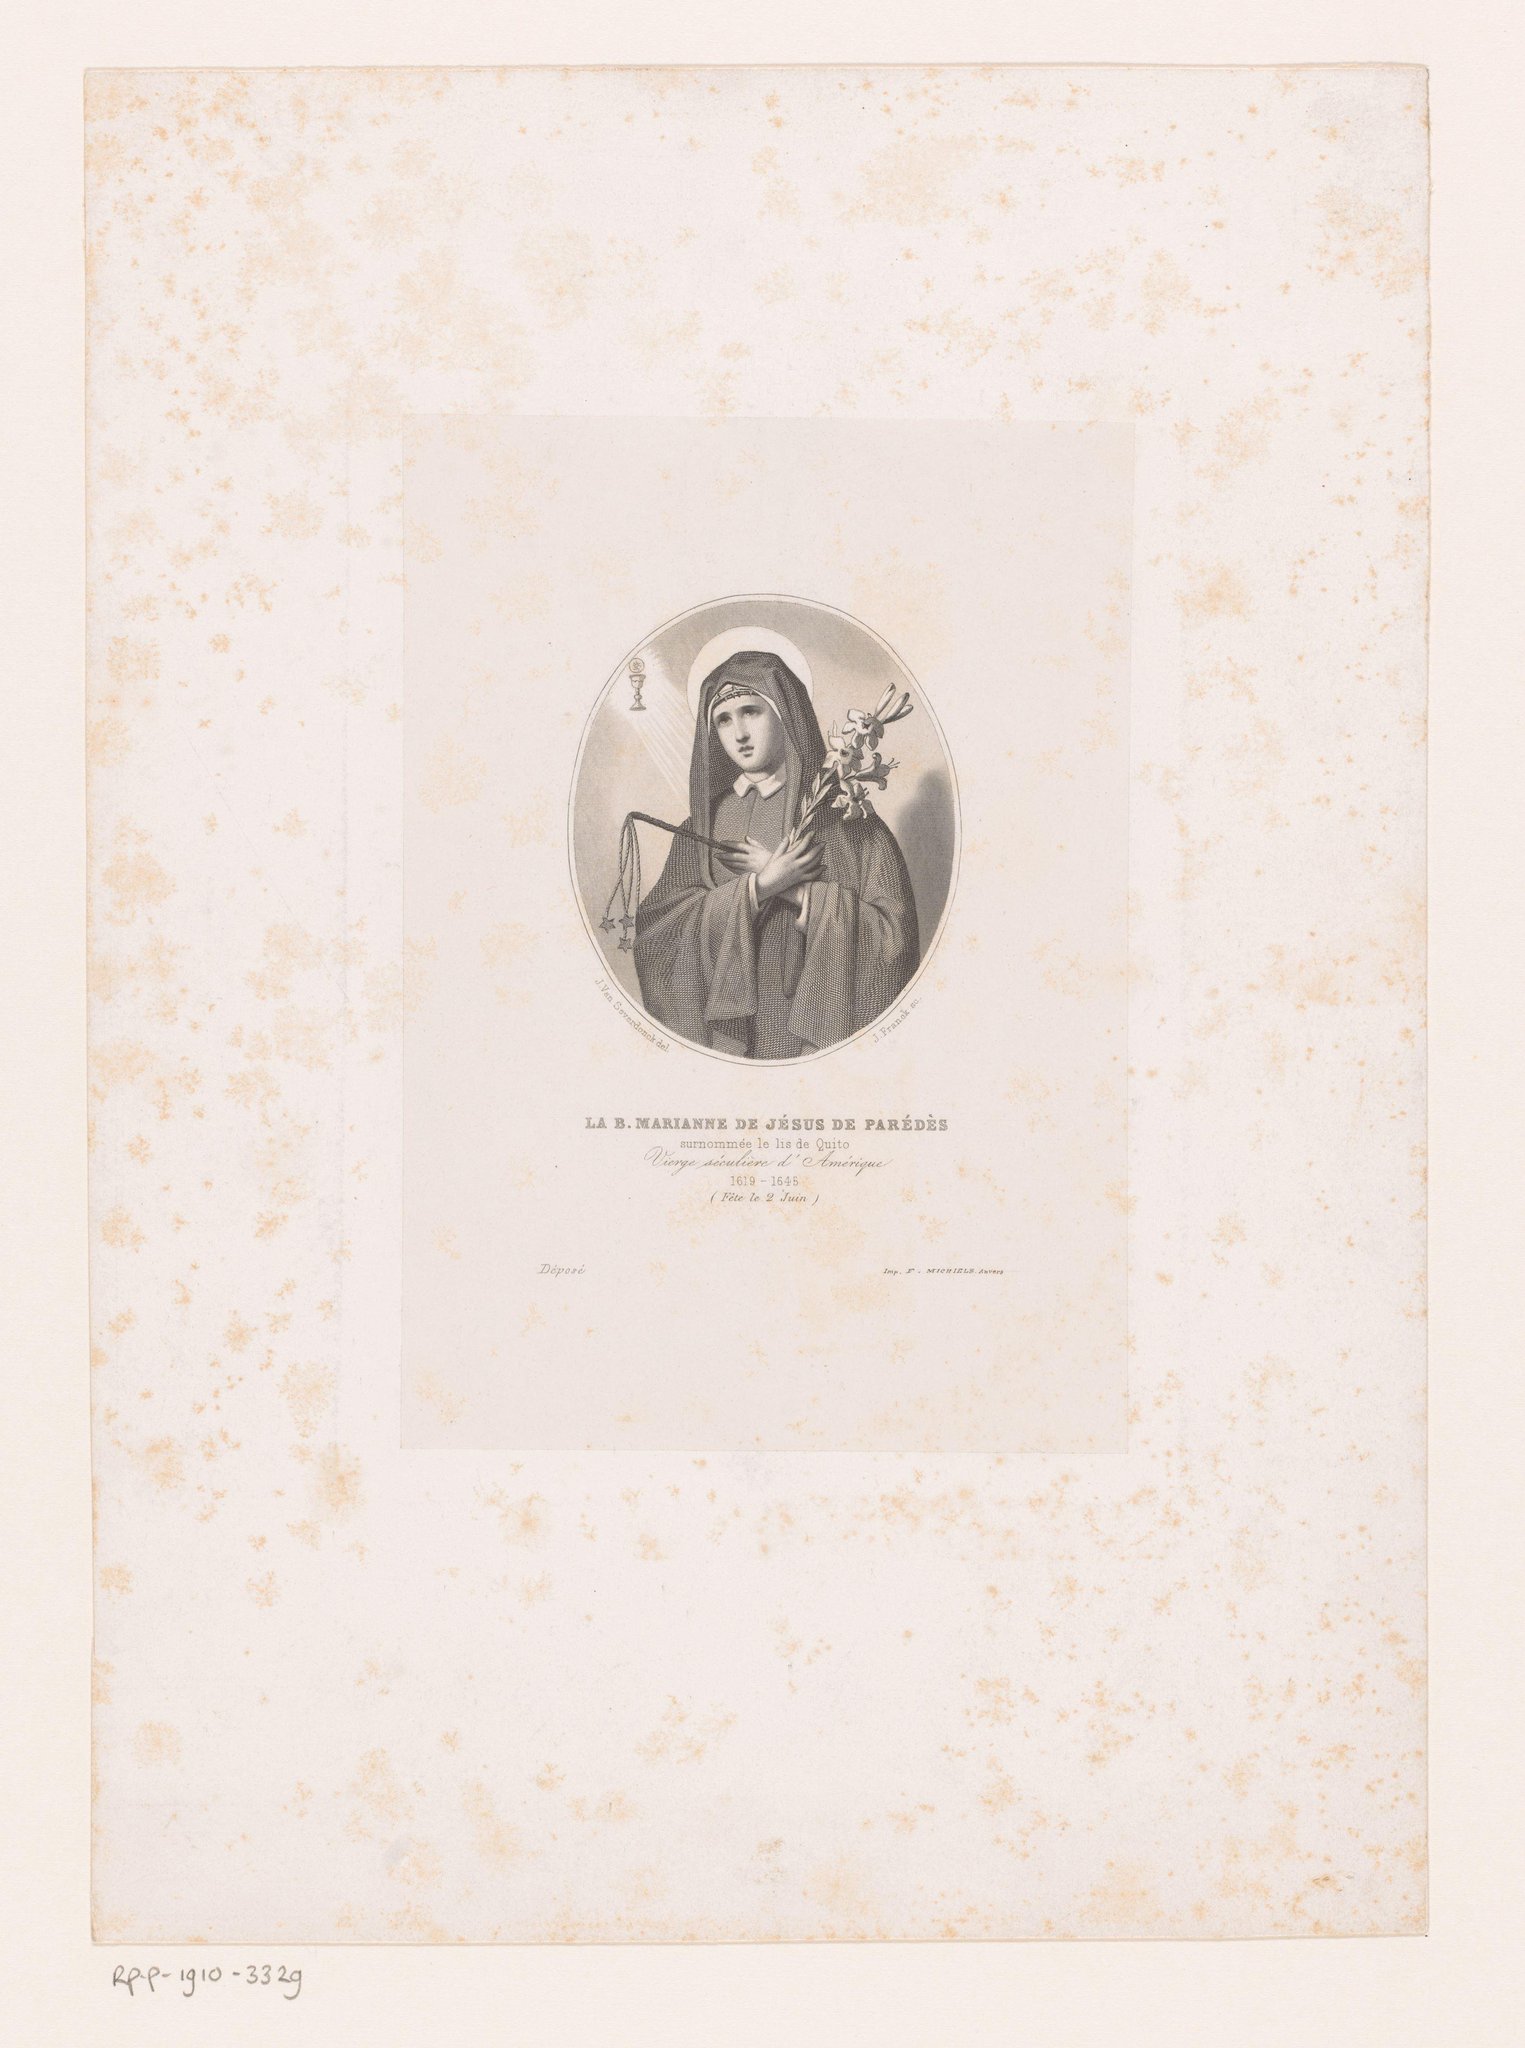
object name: print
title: La B. Marianne de Jésus de Parédès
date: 1835-1883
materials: paper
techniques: etching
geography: antwerp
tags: flowers, chalice, female saints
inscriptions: collector's mark: Lugt 2228